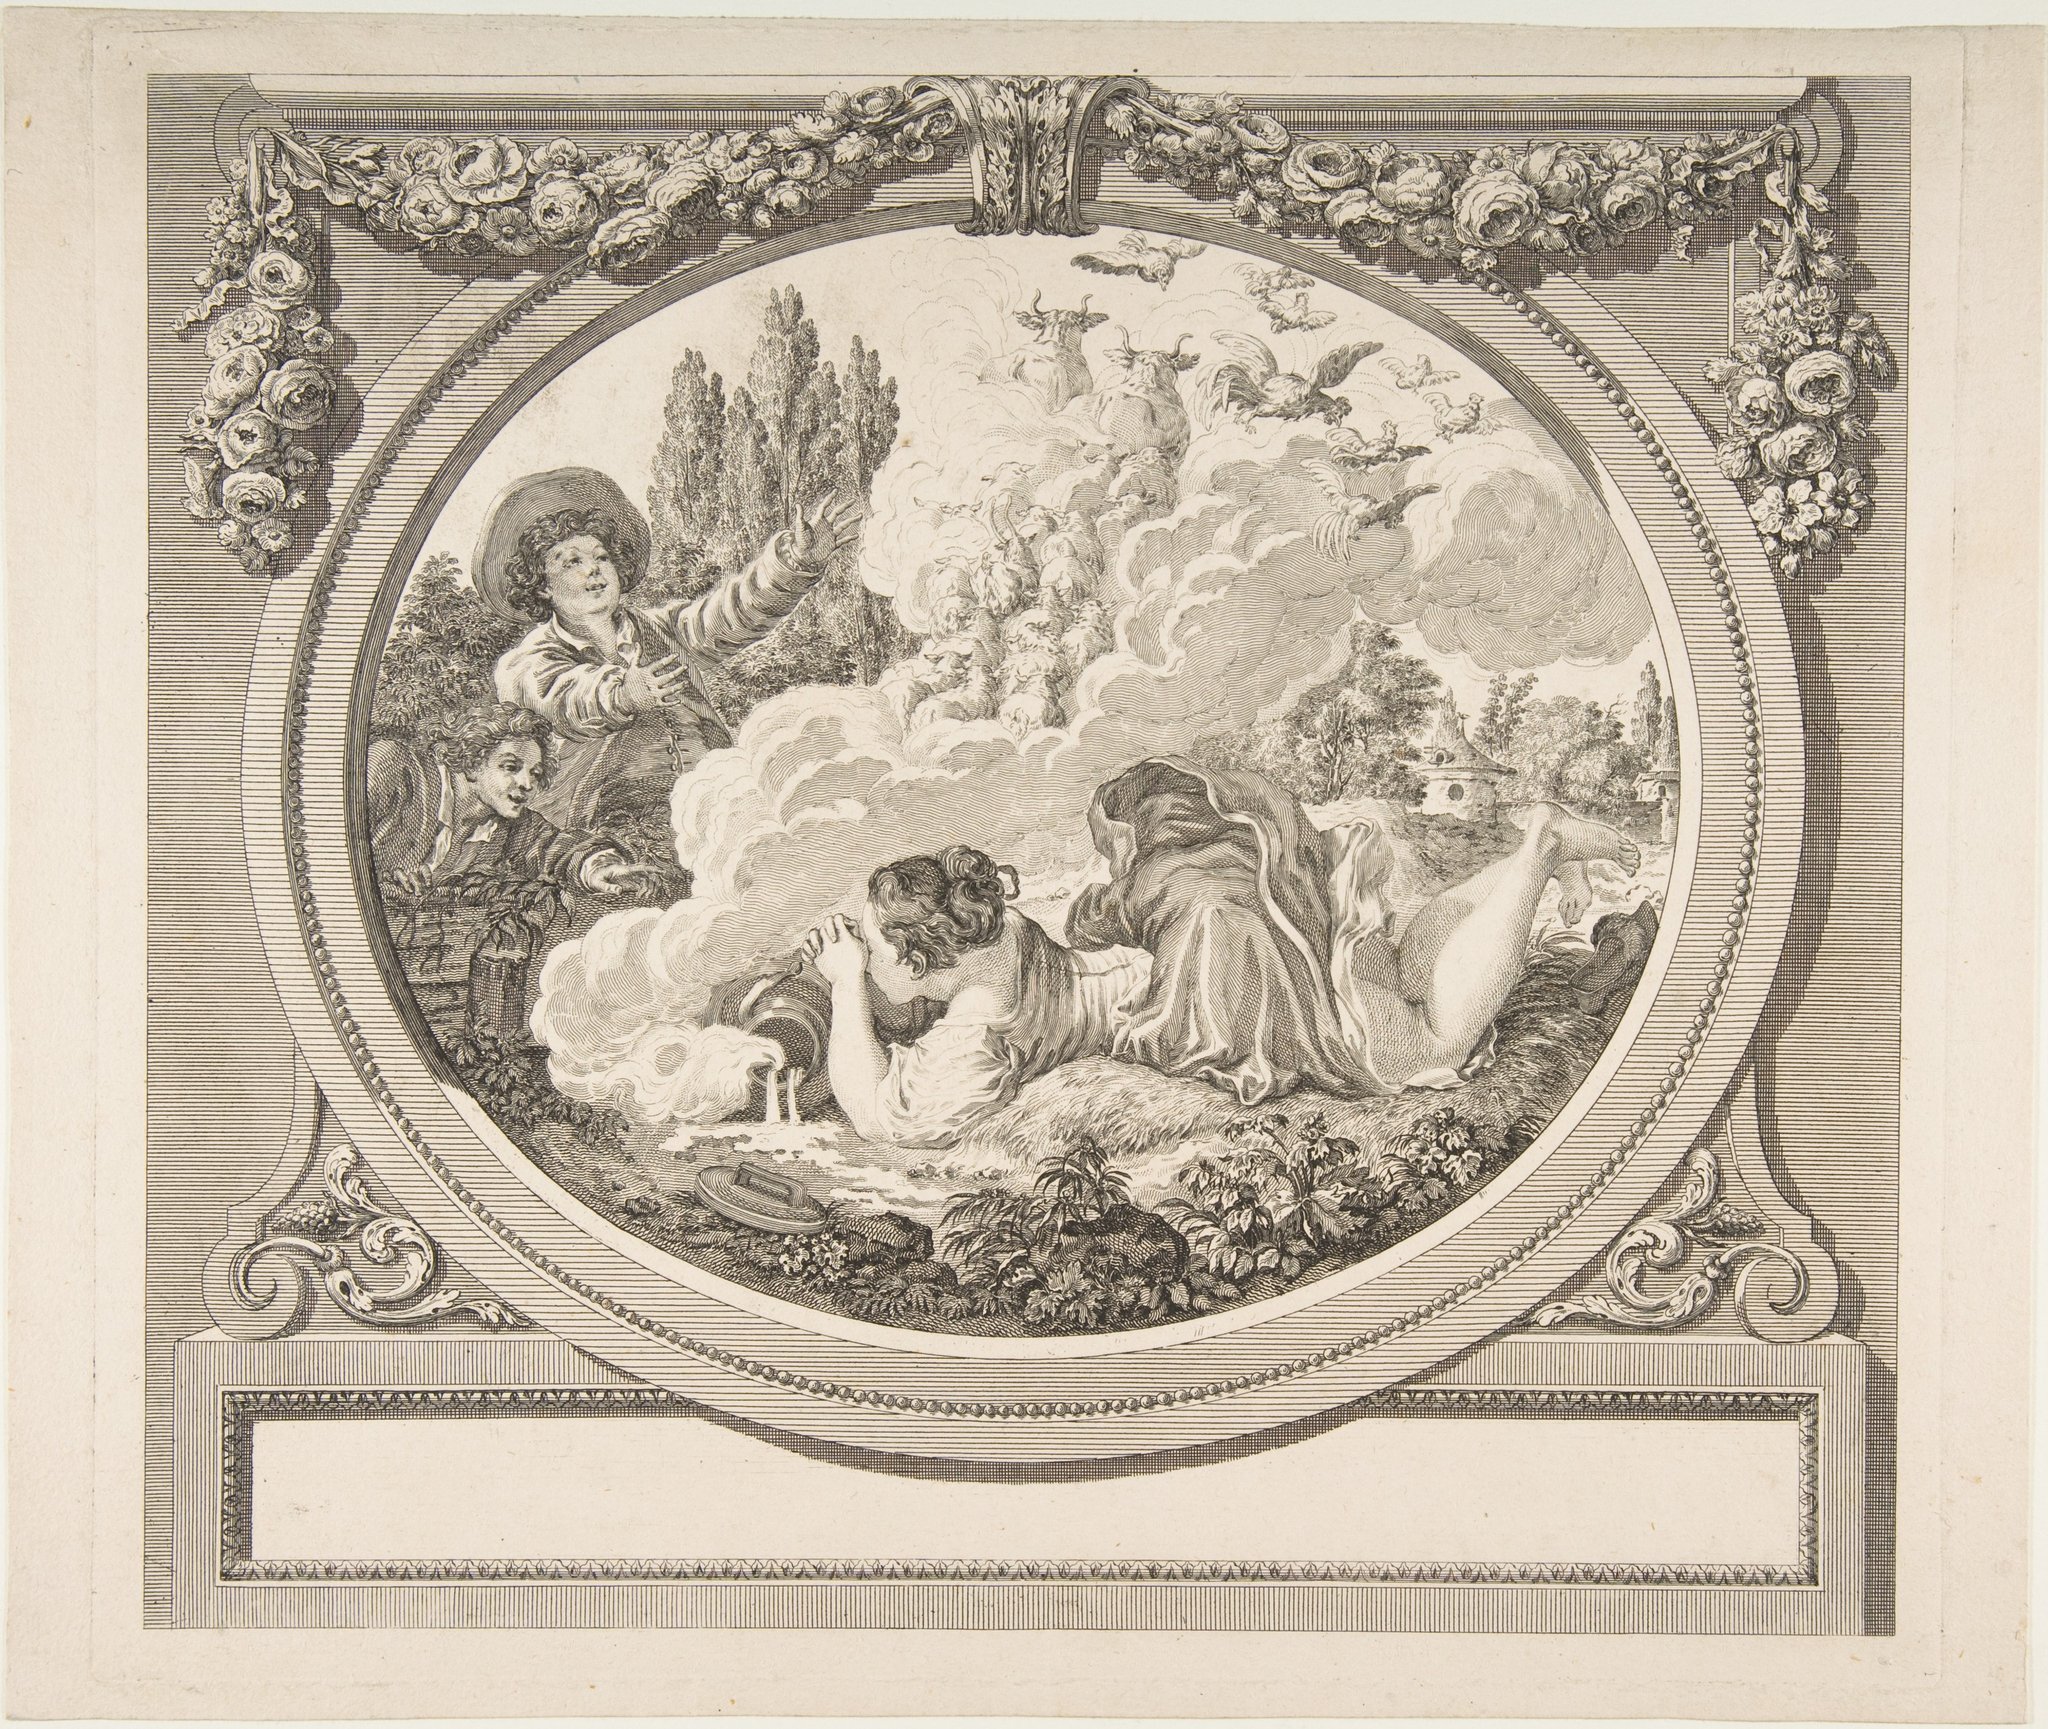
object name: print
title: Le Pot au Lait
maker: jean honoré fragonard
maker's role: artist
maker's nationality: french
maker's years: 1732-1806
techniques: etching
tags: birds,men,women,flowers